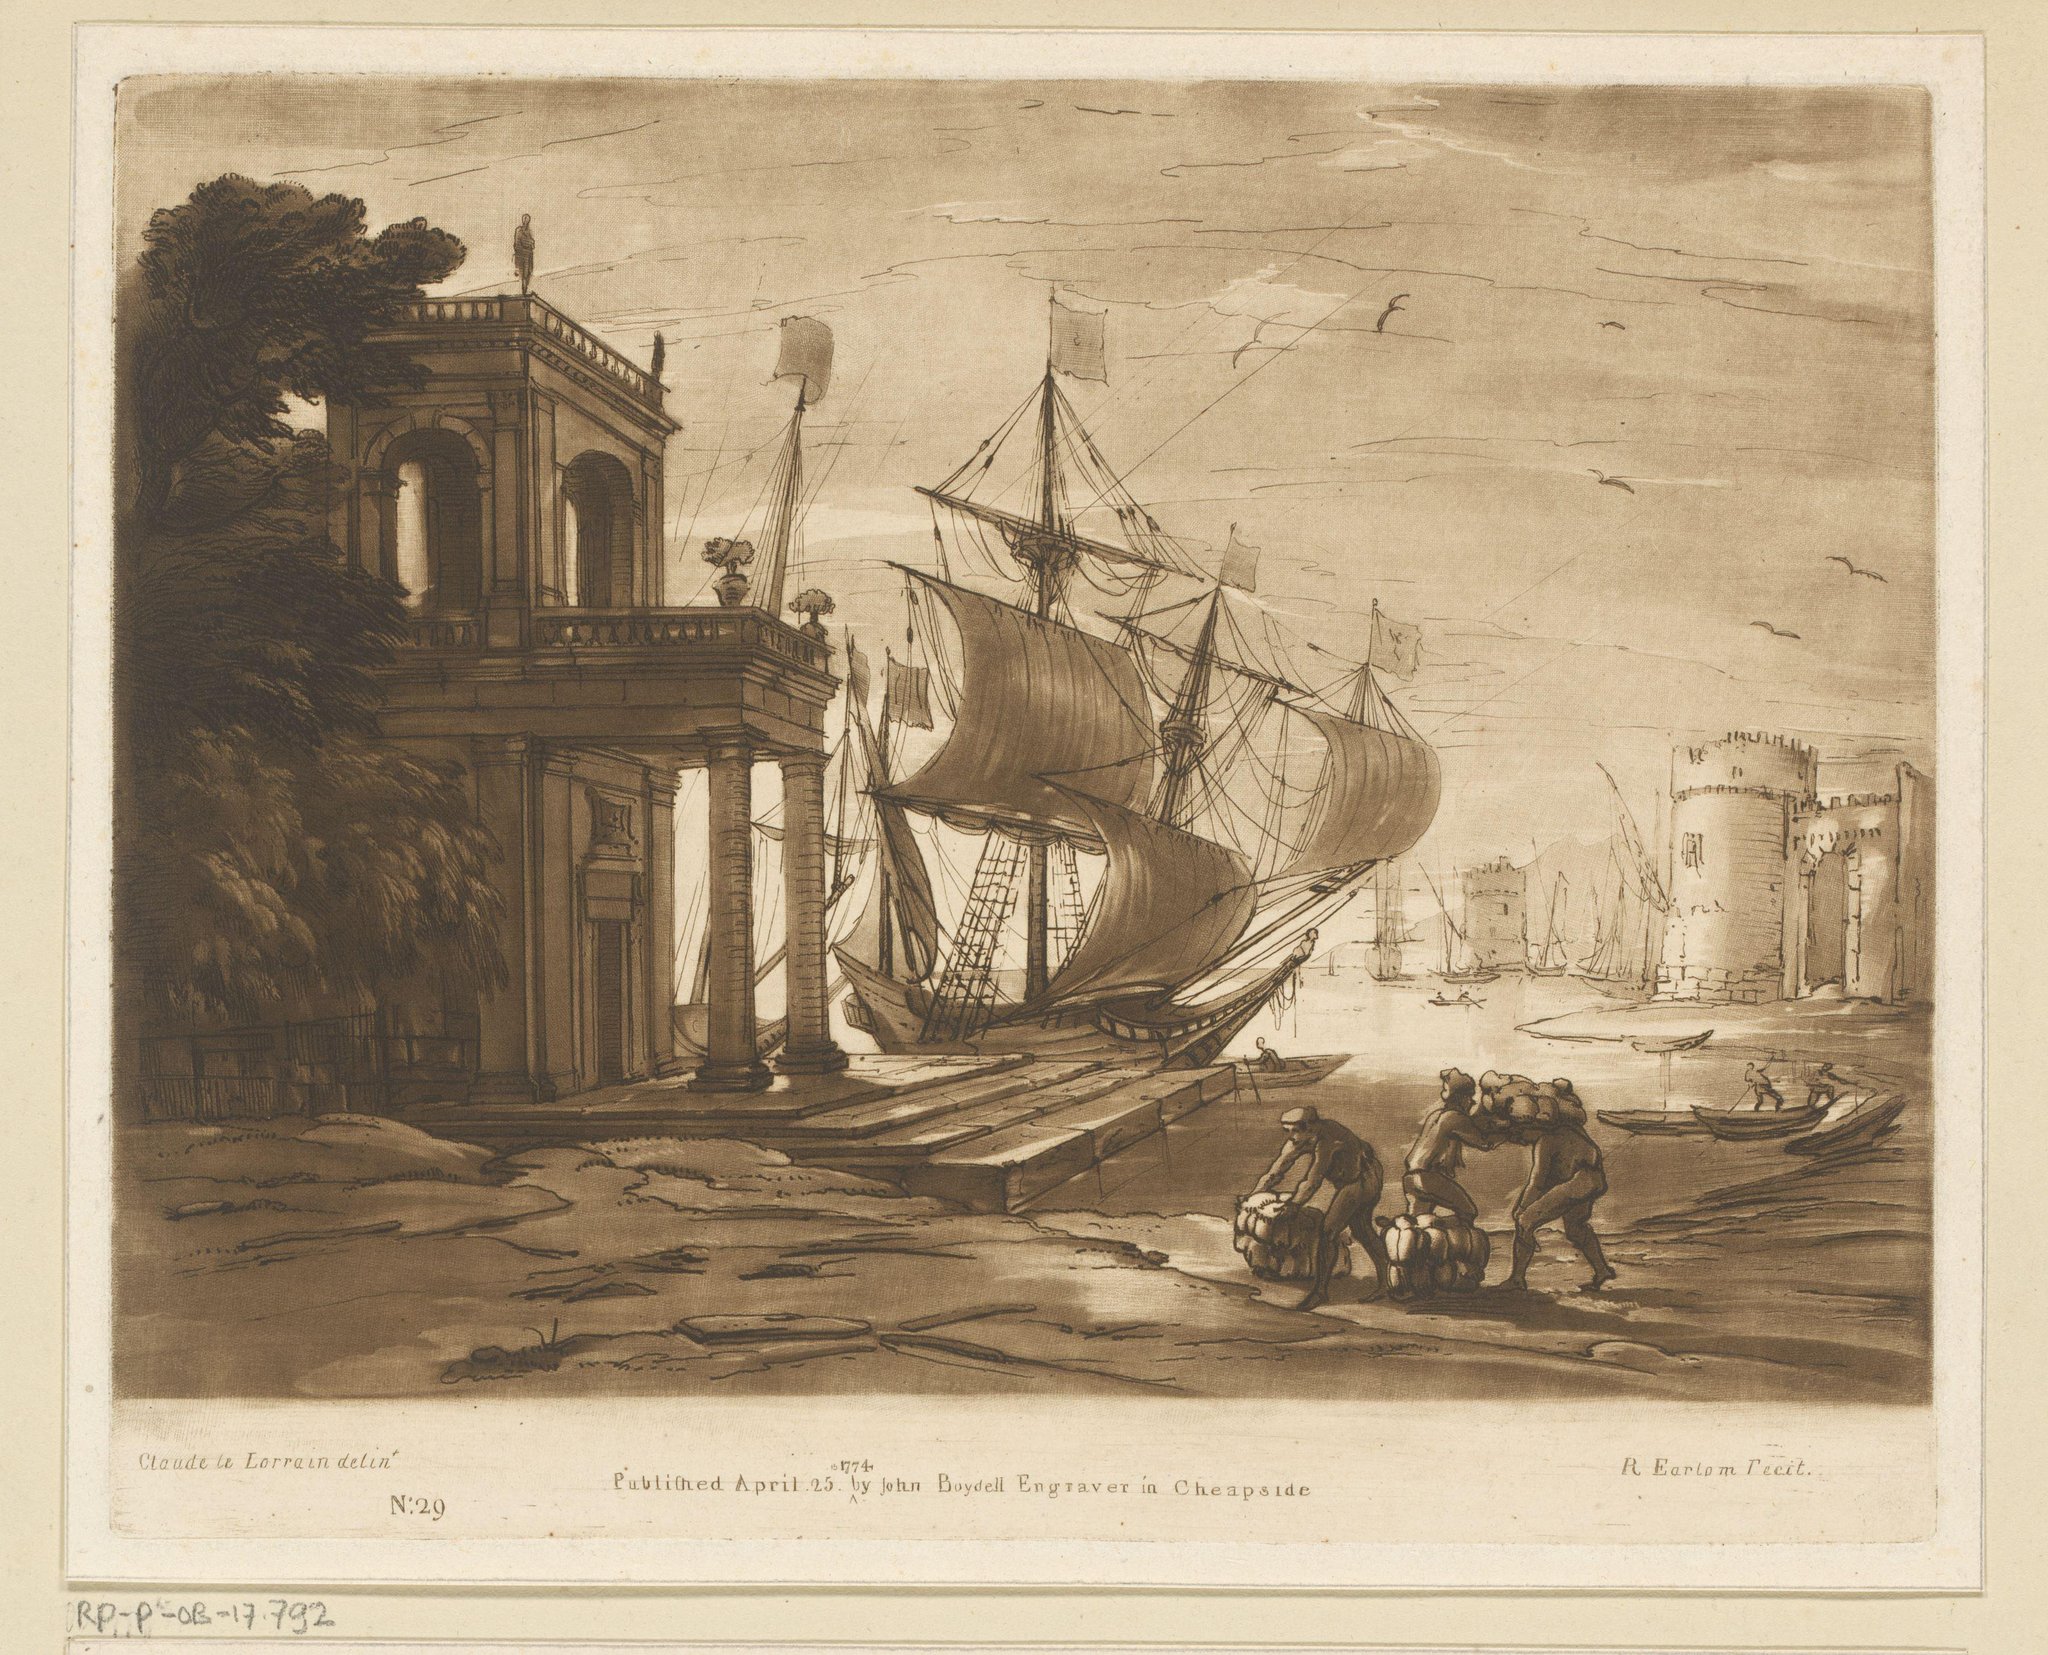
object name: print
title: Prenten naar tekeningen van Claude Lorrain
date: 1774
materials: paper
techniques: etching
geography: london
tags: sailing-ship, sailing-boat, landscapes with waters, waterscapes, seascapes (in the temperate zone), harbour (+ number of persons ~ traffic and transport)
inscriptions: date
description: Vanaf 1774 publiceerde John Boydell tweehonderd prenten naar het tekeningenboek Liber Veritatis van Claude Lorrain, in het bezit van de hertogen van Cavendish. Deze prenten werden vanaf 1777 in twee volumes gebundeld uitgegeven.